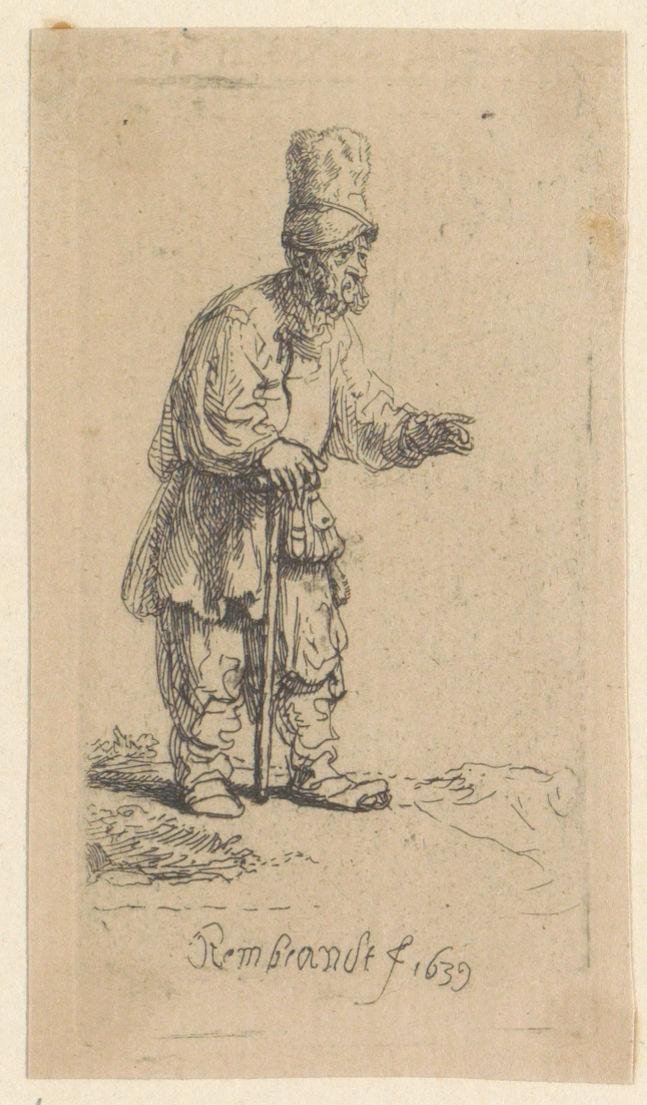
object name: print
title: Recueil de quatre-vingt-cinq estampes originales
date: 1639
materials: paper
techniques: etching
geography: paris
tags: the ages of man (+ old male (human being))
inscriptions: date